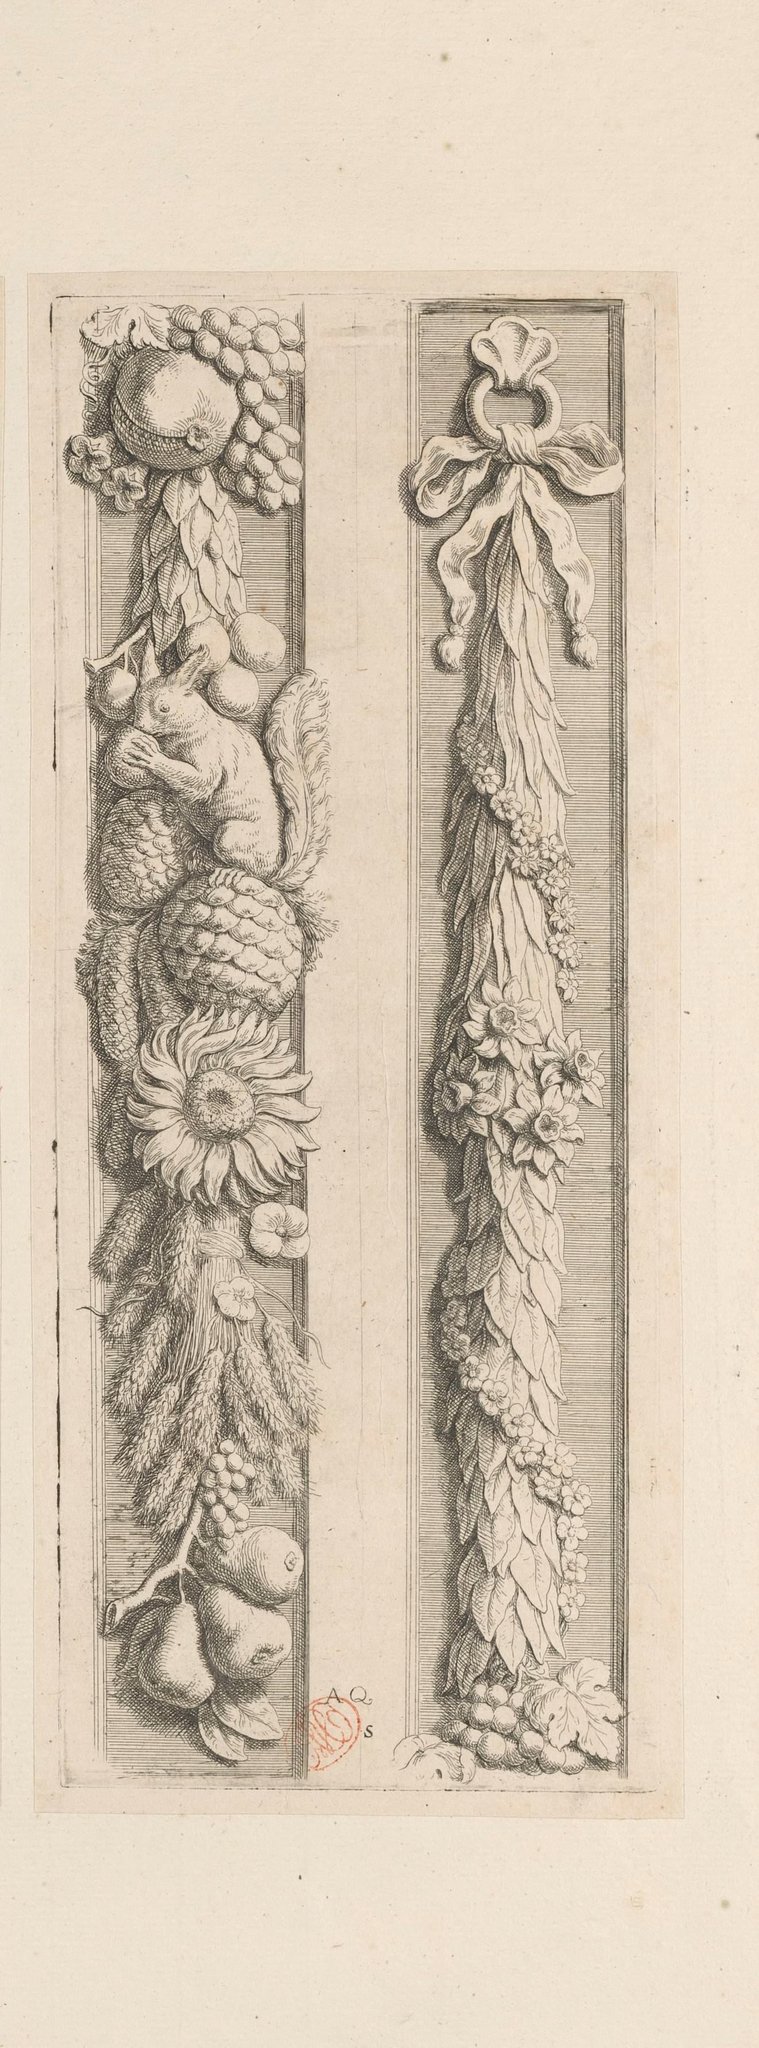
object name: book illustration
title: Pilasterfestoen met eekhoorn, fruit, bloemen, bladeren en maïs tussen galerij en Burgerzaal in het Stadhuis op de Dam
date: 1655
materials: paper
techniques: engraving, etching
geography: amsterdam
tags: fruits: pine-cone, fruits and vegetables ~ ornament, ornament ~ festoon, garland, rodents: squirrel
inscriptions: collector's mark: Lugt 195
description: Prent gebruikt in: Prima pars. Praecipuarum effigierum ac ornamentorum, amplissimae Curiae Amstelrodamensis (…) / Het eerste deel. Van de voornaemste Statuen ende Ciraten, vant konstijck Stadhuys van Amstelredam, tmeeste in marmer gemaeckt, door Artus Quellinus, Beelthouwer der voorseyde Stadt / La Premier Partie. De plusieurs Figures et ornements, de la Maison de Ville d'Amsterdam (…). Amsterdam: Artus Quellinus (I), 1655. Zie RP-P-AO-22-1-1 voor bijhorende titelpagina. Zie RP-P-AO-22-1-2 voor bijhorend register. Zie RP-P-AO-22-1A, RP-P-AO-22-1B, RP-P-AO-22-1C, RP-P-AO-22-1D-1, RP-P-AO-22-1D-2, RP-P-AO-22-1E, RP-P-AO-22-1F, RP-P-AO-22-1G, RP-P-AO-22-1H, RP-P-AO-22-1I, RP-P-AO-22-1K-1, RP-P-AO-22-1K-2, RP-P-AO-22-1K-3, RP-P-AO-22-1K-4, RP-P-AO-22-1K-5, RP-P-AO-22-1L-1, RP-P-AO-22-1L-2, RP-P-AO-22-1M-1, RP-P-AO-22-1M-2, RP-P-AO-22-1N-1, RP-P-AO-22-1N-2, RP-P-AO-22-1N-3, RP-P-AO-22-1N-4, RP-P-AO-22-1N-5, RP-P-AO-22-1O-1, RP-P-AO-22-1O-2, RP-P-AO-22-1O-3, RP-P-AO-22-1O-4, RP-P-AO-22-1P-1, RP-P-AO-22-1P-2, RP-P-AO-22-1P-3, RP-P-AO-22-1P-4, RP-P-AO-22-1Q-1, RP-P-AO-22-1Q-2, RP-P-AO-22-1Q-3, RP-P-AO-22-1Q-4, RP-P-AO-22-1R-1, RP-P-AO-22-1R-2, RP-P-AO-22-1R-3, RP-P-AO-22-1R-4, RP-P-AO-22-1R-5, RP-P-AO-22-1S-1, RP-P-AO-22-1S-2, RP-P-AO-22-1S-3, RP-P-AO-22-1S-5, RP-P-AO-22-1T-1 en RP-P-AO-22-1T-2 voor andere prenten uit deze publicatie. Zelfde staat van prent ook gebruikt in: Prima pars. Praecipuarum effigierum ac ornamentorum, amplissimae Curiae Amstelrodamensis (…) / Het eerste deel. Van de voornaemste Statuen ende Ciraten, vant konstijck Stadhuys van Amstelredam, tmeeste in marmer gemaeckt, door Artus Quellinus, Beelthouwer der voorseyde Stadt / La Premier Partie. De plusieurs Figures et ornements, de la Maison de Ville d'Amsterdam (…). Amsterdam: Frederik de Wit, 1665. Latere staat van prent ook gebruikt in: Architecture peinture et sculpture de la Maison de Ville d'Amsterdam, representee en CIX. figures en taille-douce (…). Amsterdam: David Mortier, 1719. En in: Architecture peinture et sculpture de la Maison de Ville d'Amsterdam, representee en CIX. figures en taille-douce (…). Amsterdam: Gerard Valck, 1719. En in: Bouw schilder en beeldhouwkonst, van het Stadhuis te Amsteldam, vertoont in CIX figuuren (…). Amsterdam: Covens & Mortier & Covens Jr., s.a. (1774-1783).